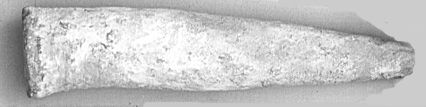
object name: cone, uninscribed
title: Funerary cone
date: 2124-1981 BCE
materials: paint, pottery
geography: egypt